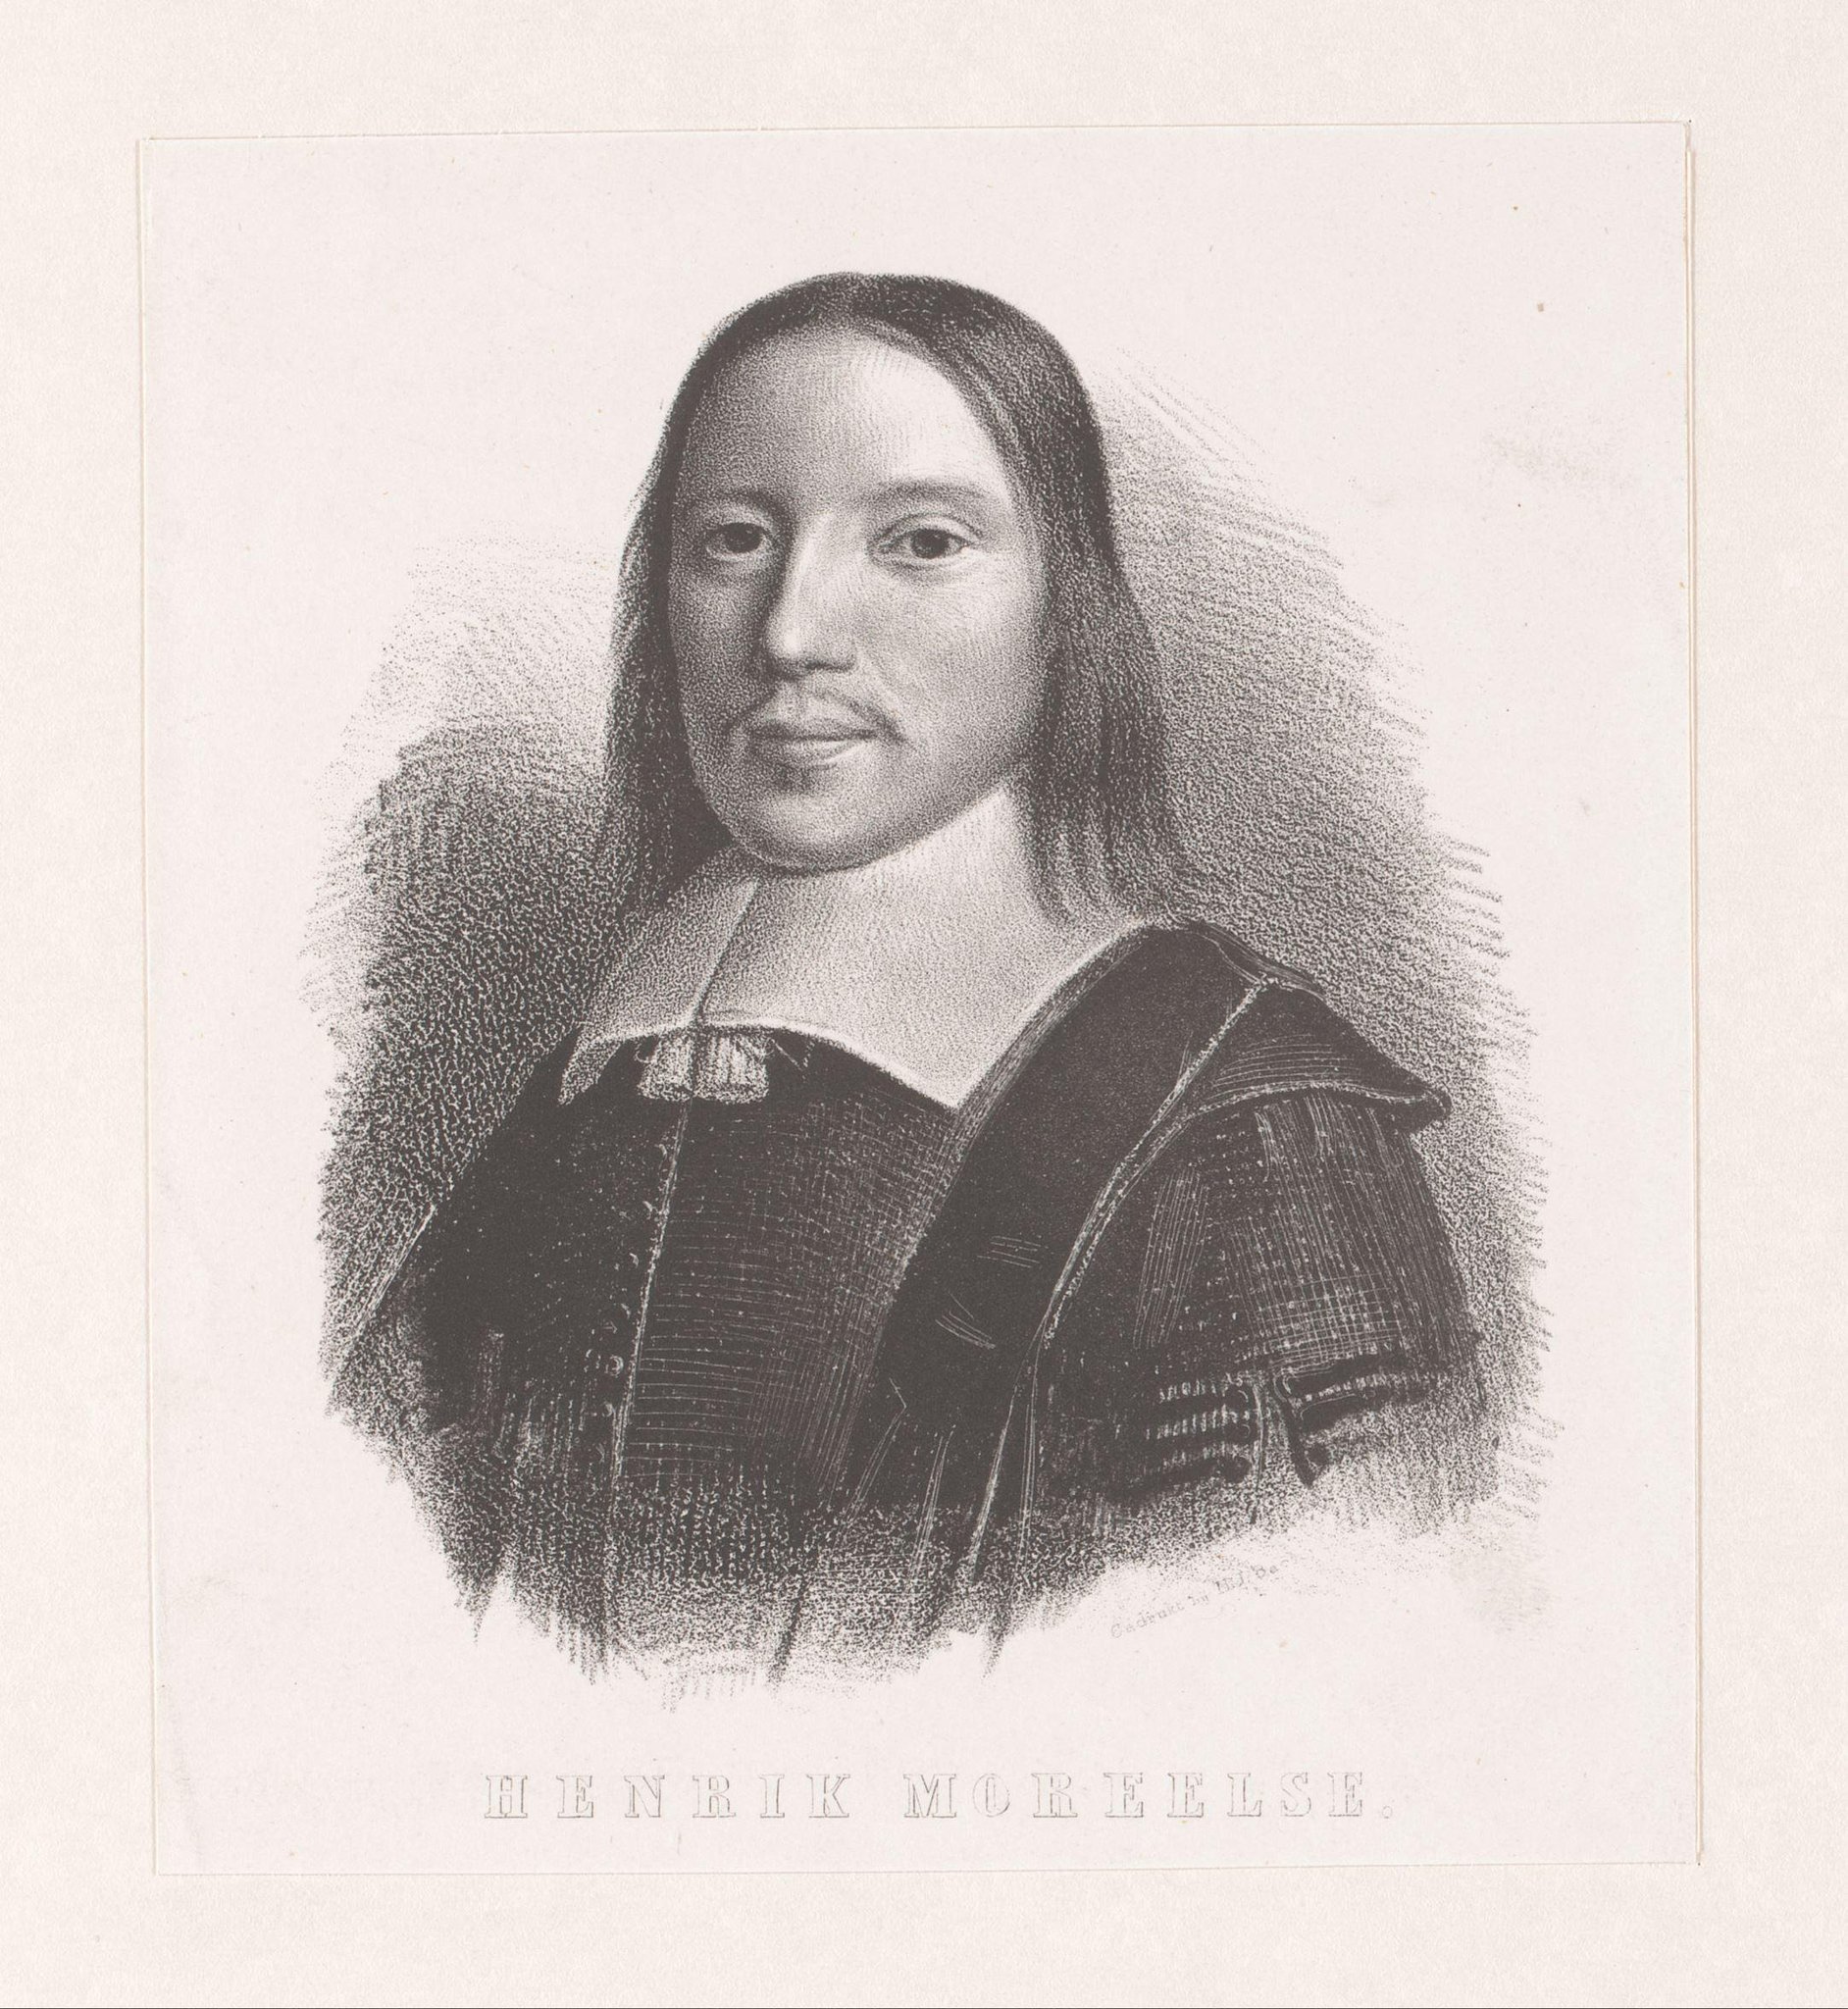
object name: print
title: Henrik Moreelse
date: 1822-1845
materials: paper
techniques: lithograph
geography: dordrecht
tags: historical persons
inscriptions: collector's mark: Lugt 2228